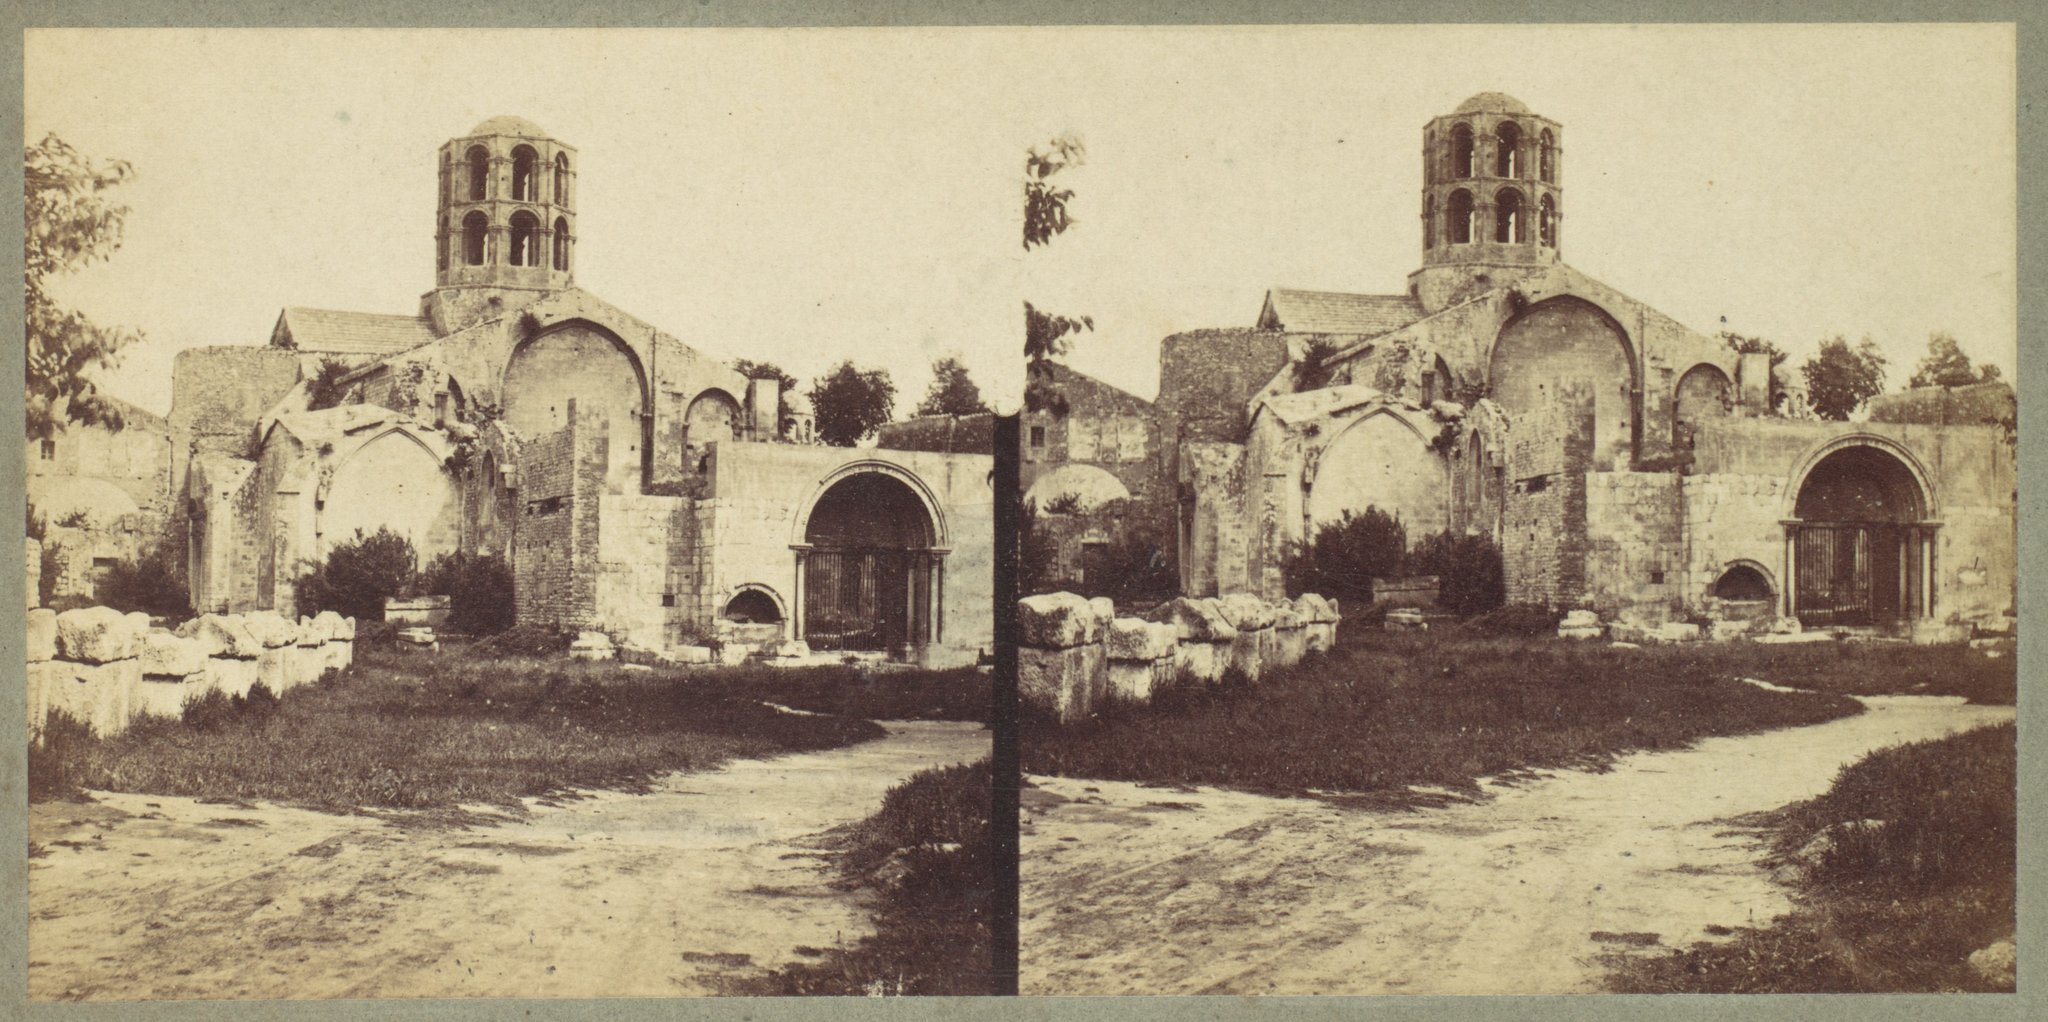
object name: stereograph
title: [Church of Saint-Honorat, Arles]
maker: édouard denis baldus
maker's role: fotograaf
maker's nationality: french, born prussia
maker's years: 1813-1889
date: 1864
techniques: albumen silver print, glass negative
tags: architecture,churches